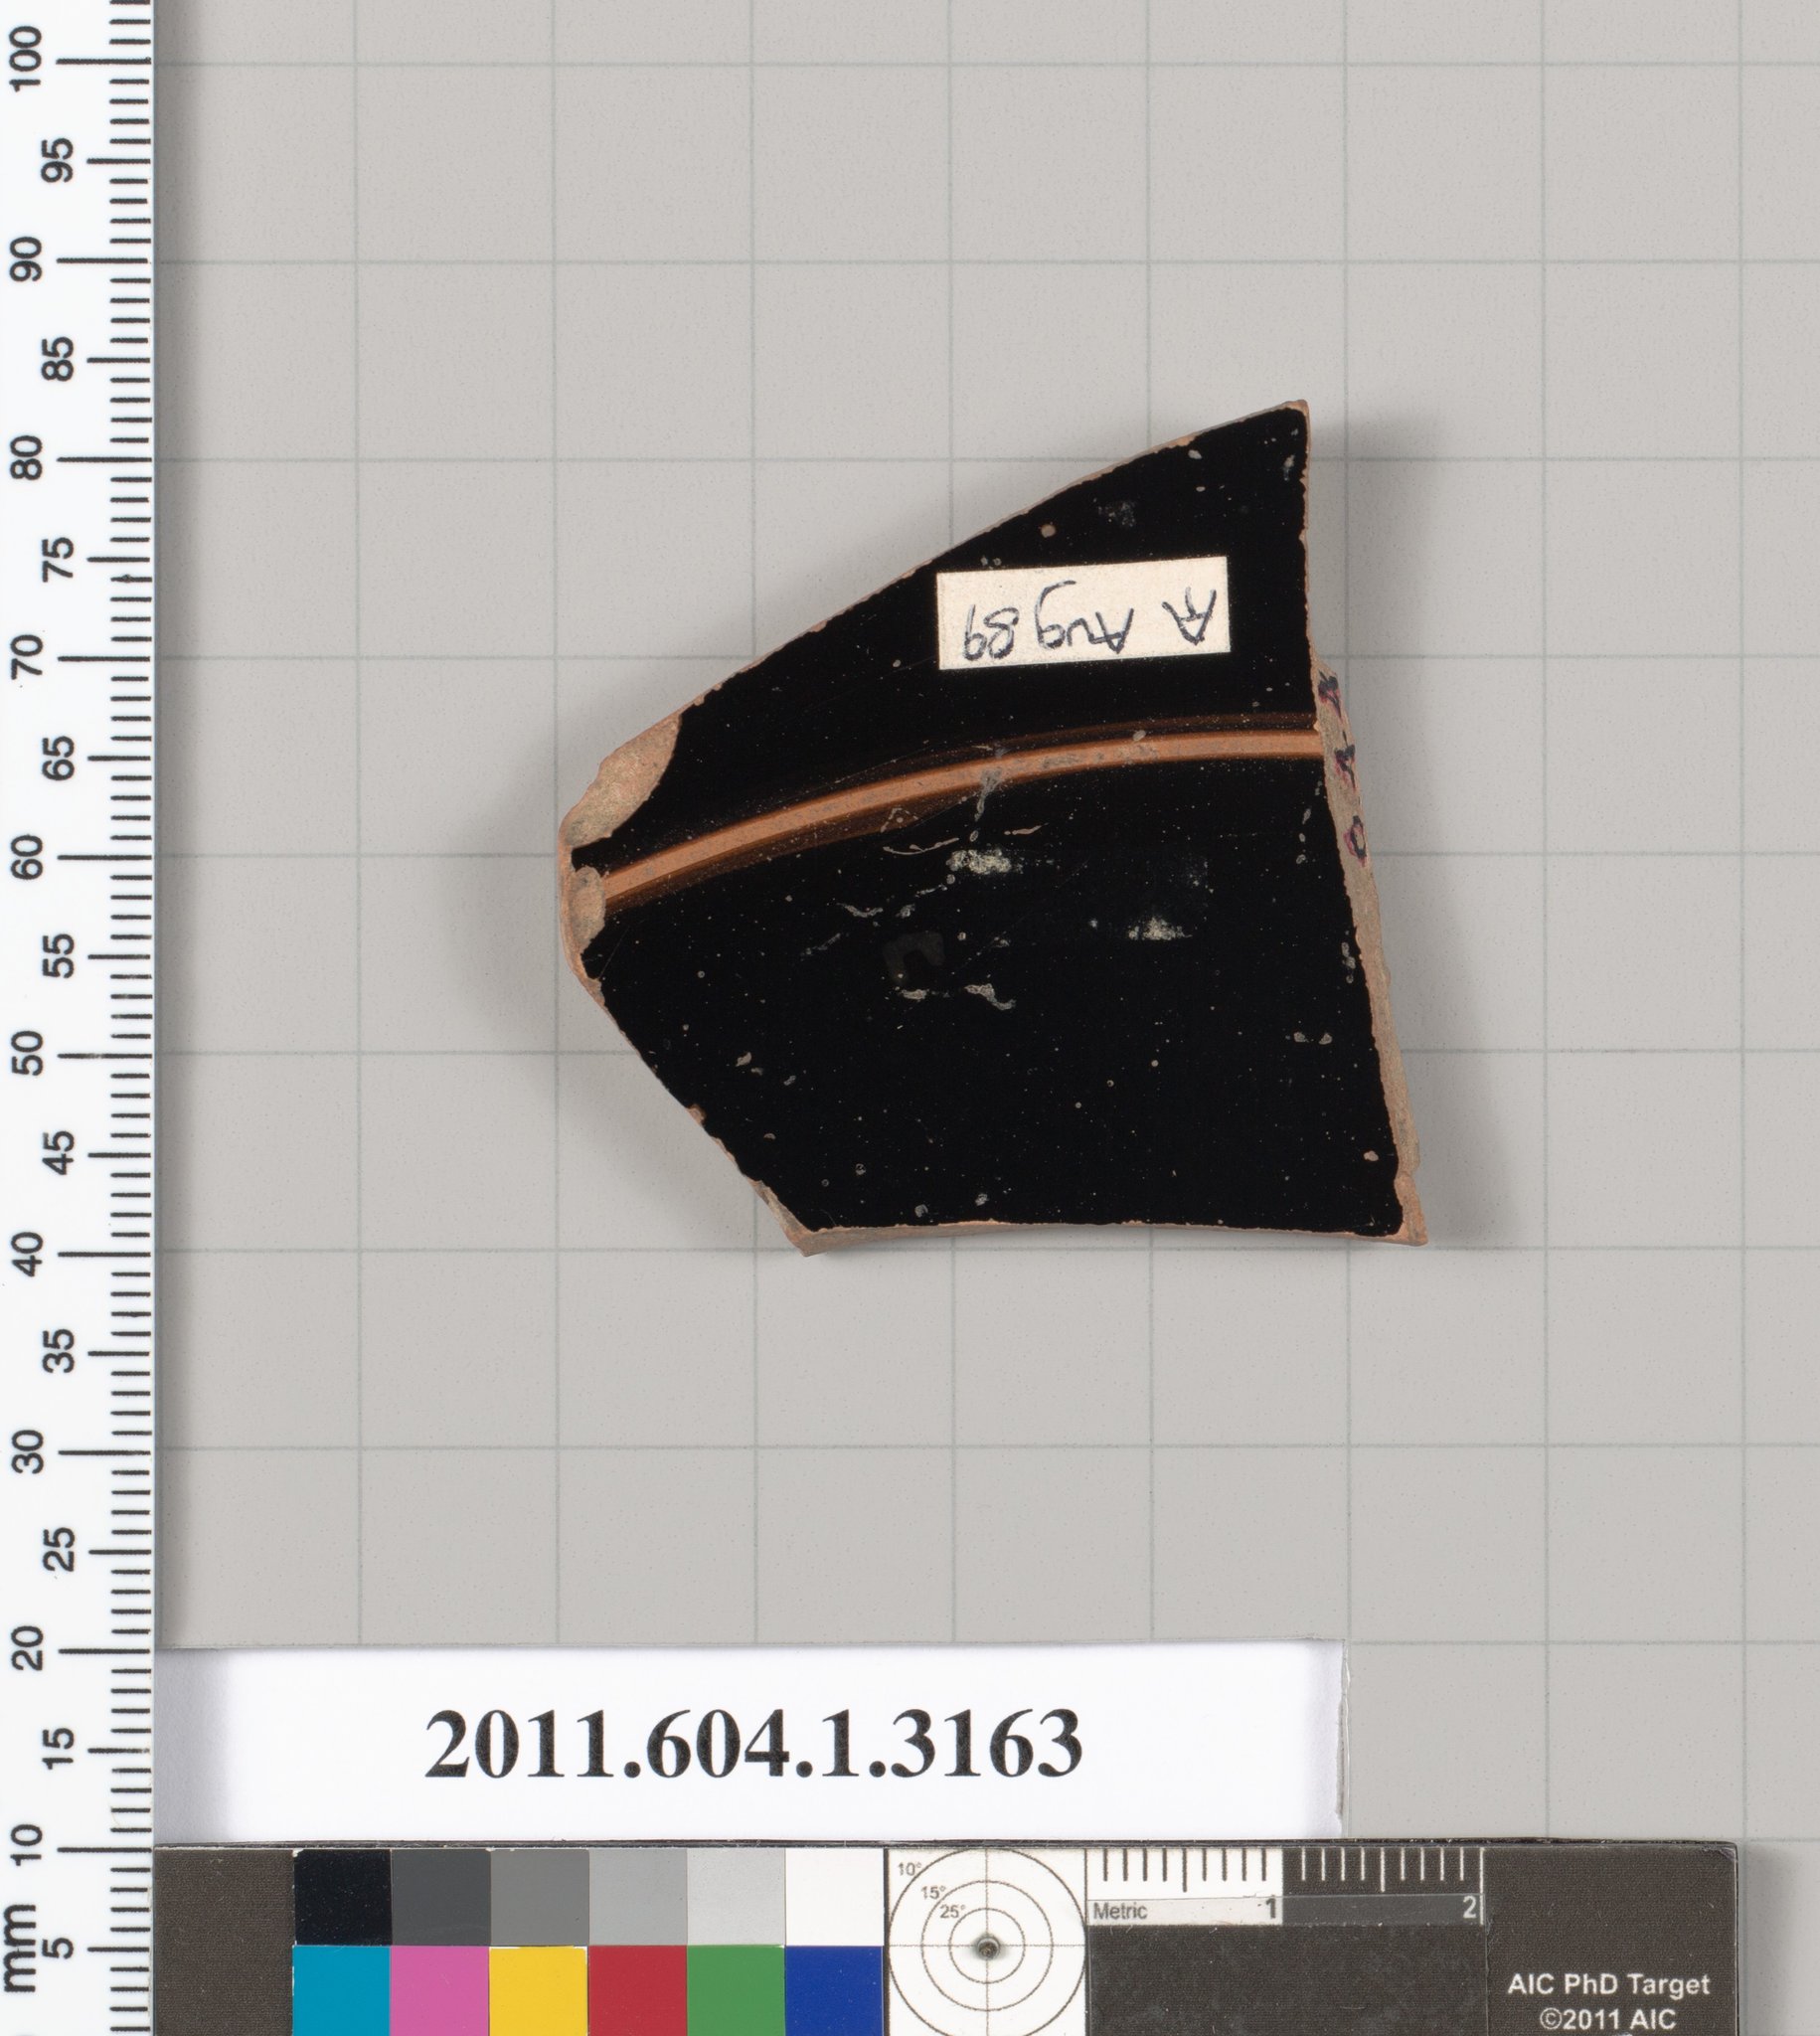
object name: kylix fragment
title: Terracotta fragment of a kylix (drinking cup)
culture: greek, attic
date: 520-500 BCE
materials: terracotta